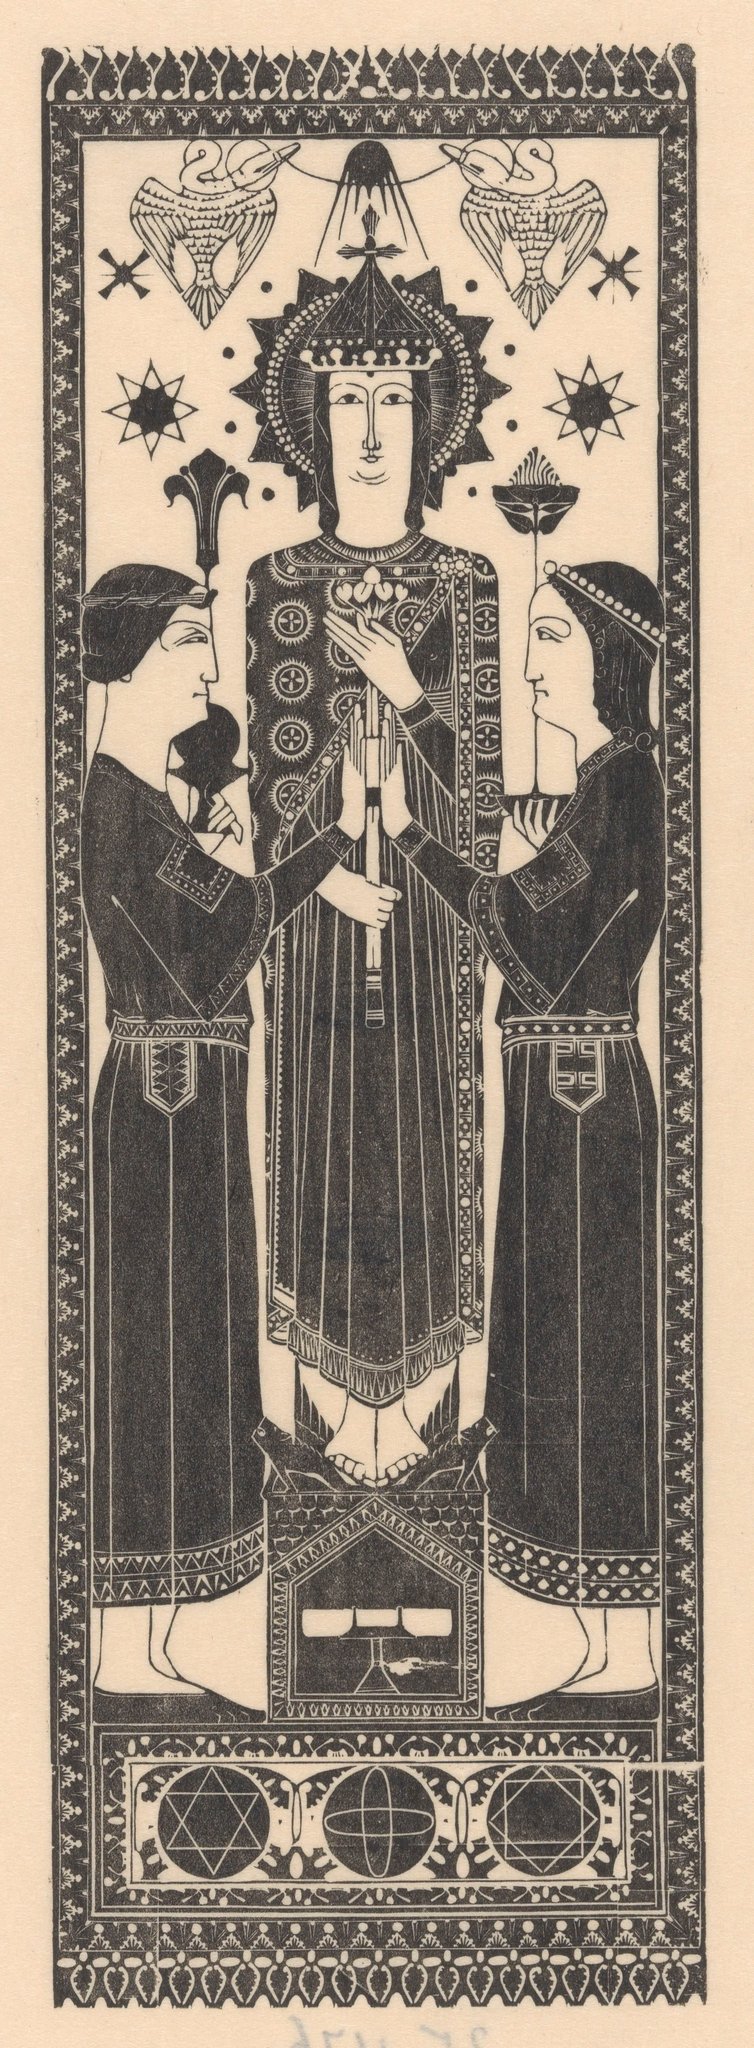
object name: print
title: Drie figuren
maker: mathieu lauweriks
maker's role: designer, draughtsman, print maker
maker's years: 1864-1932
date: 1874-1932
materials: paper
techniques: woodcut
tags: standing figure, art, religion and magic, philosophy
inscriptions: collector's mark: Lugt 2228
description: Drie figuren die godsdienst, filosofie en kunst vertegenwoordigen. Bovenaan twee vogels.